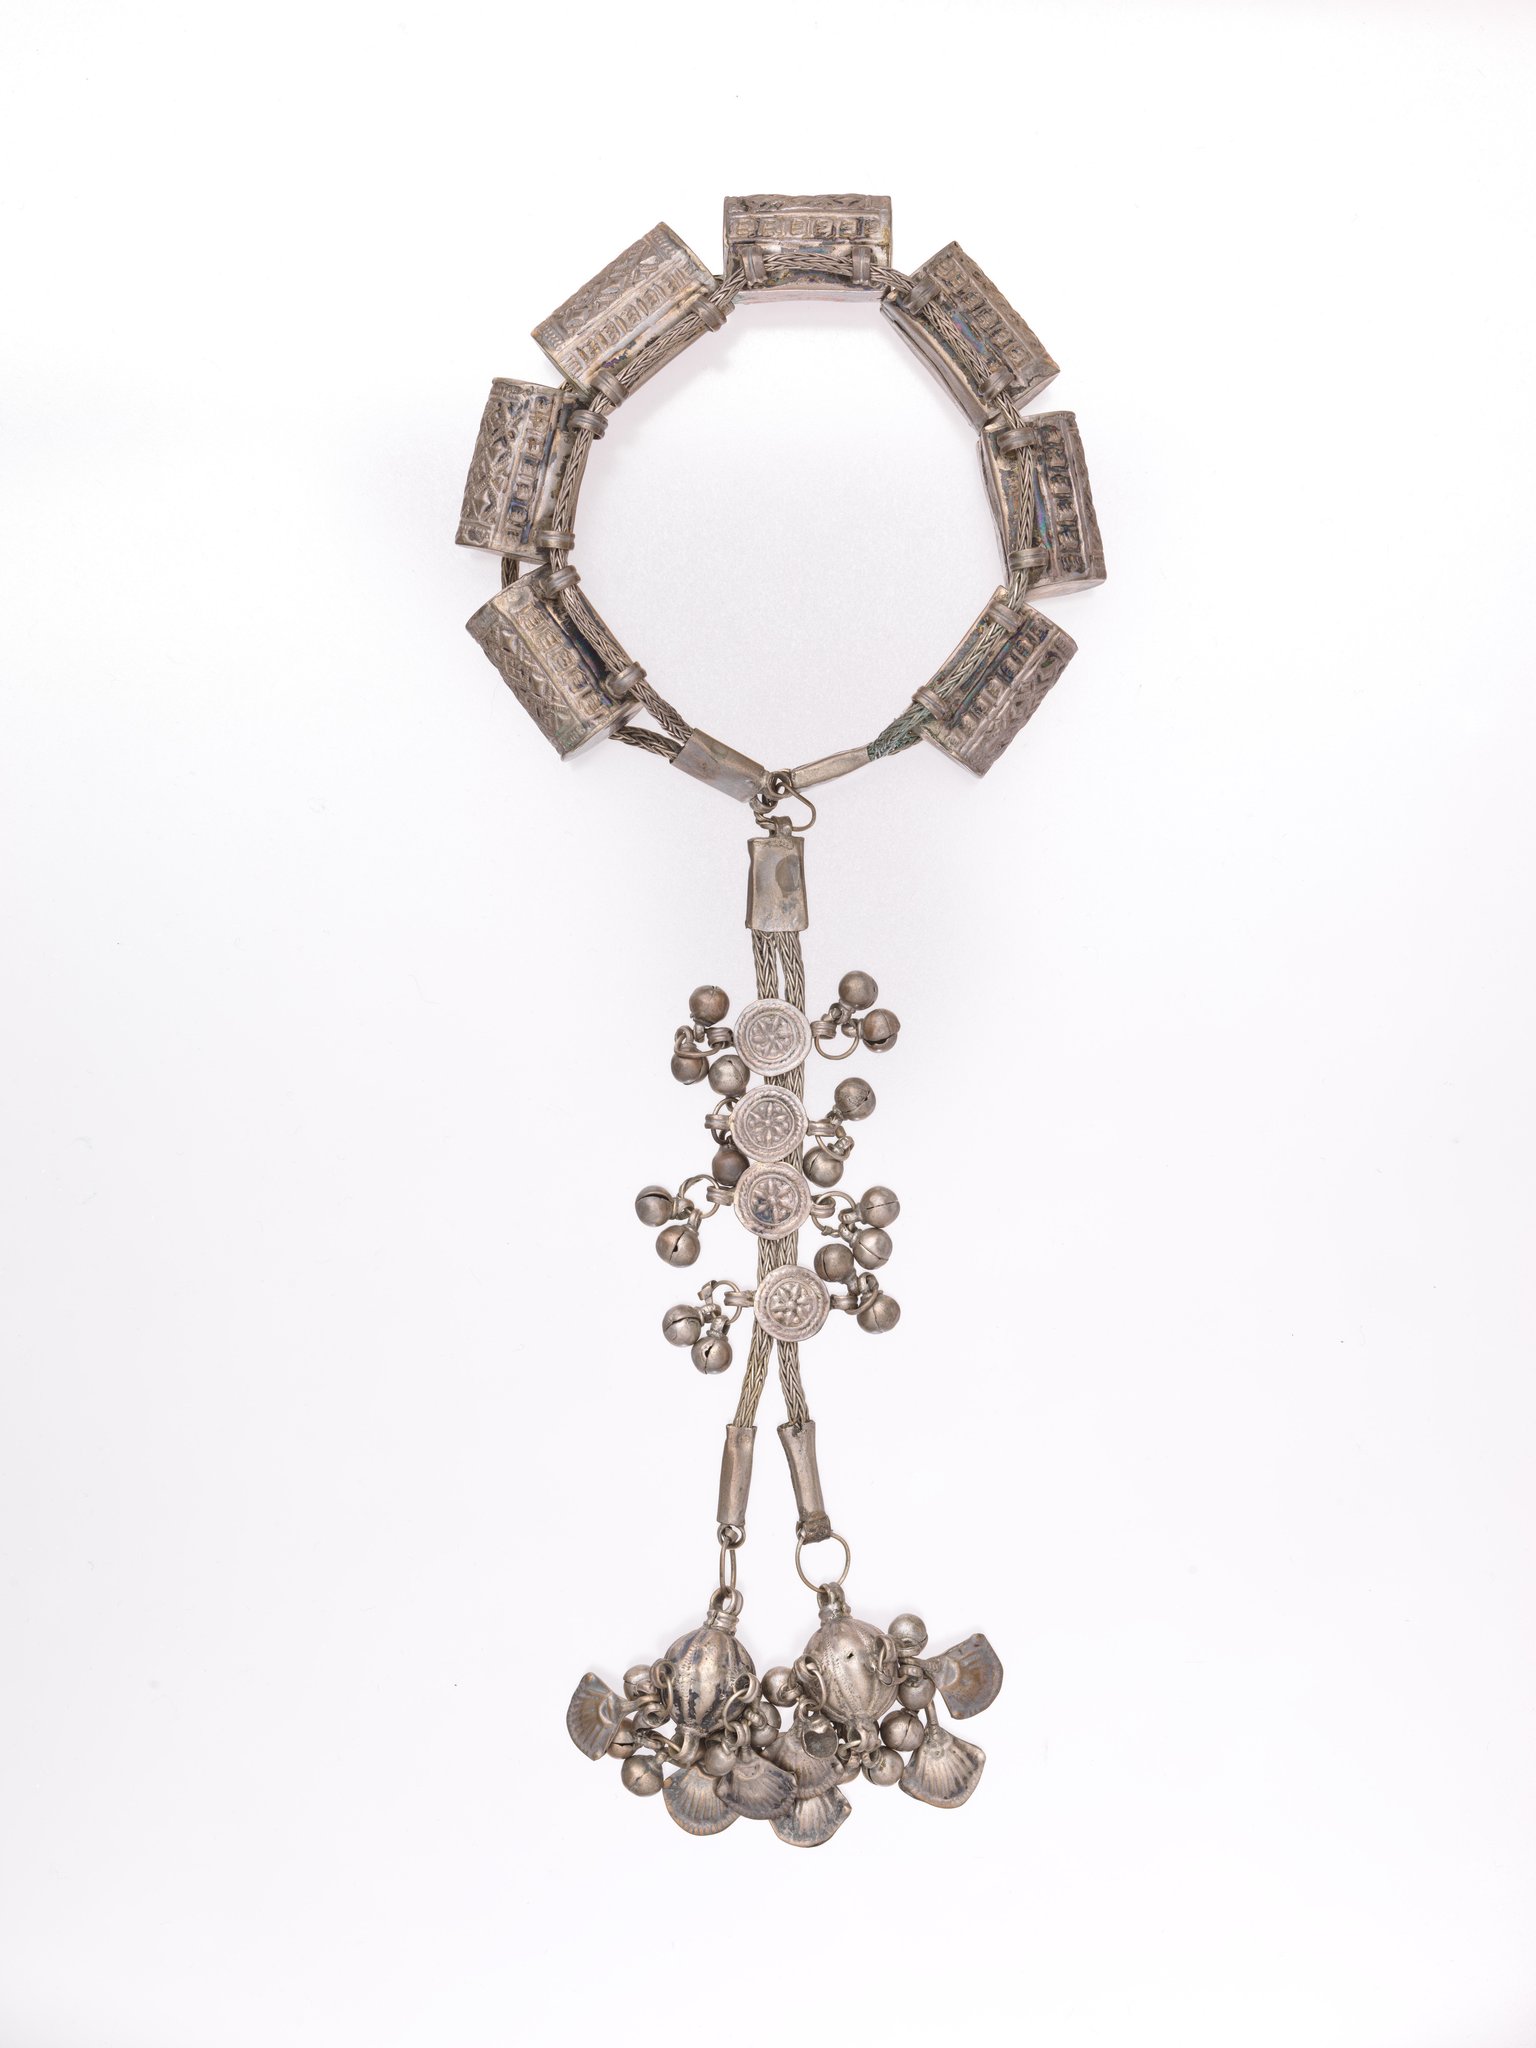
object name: armlet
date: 1701-1900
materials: silver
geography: northern india